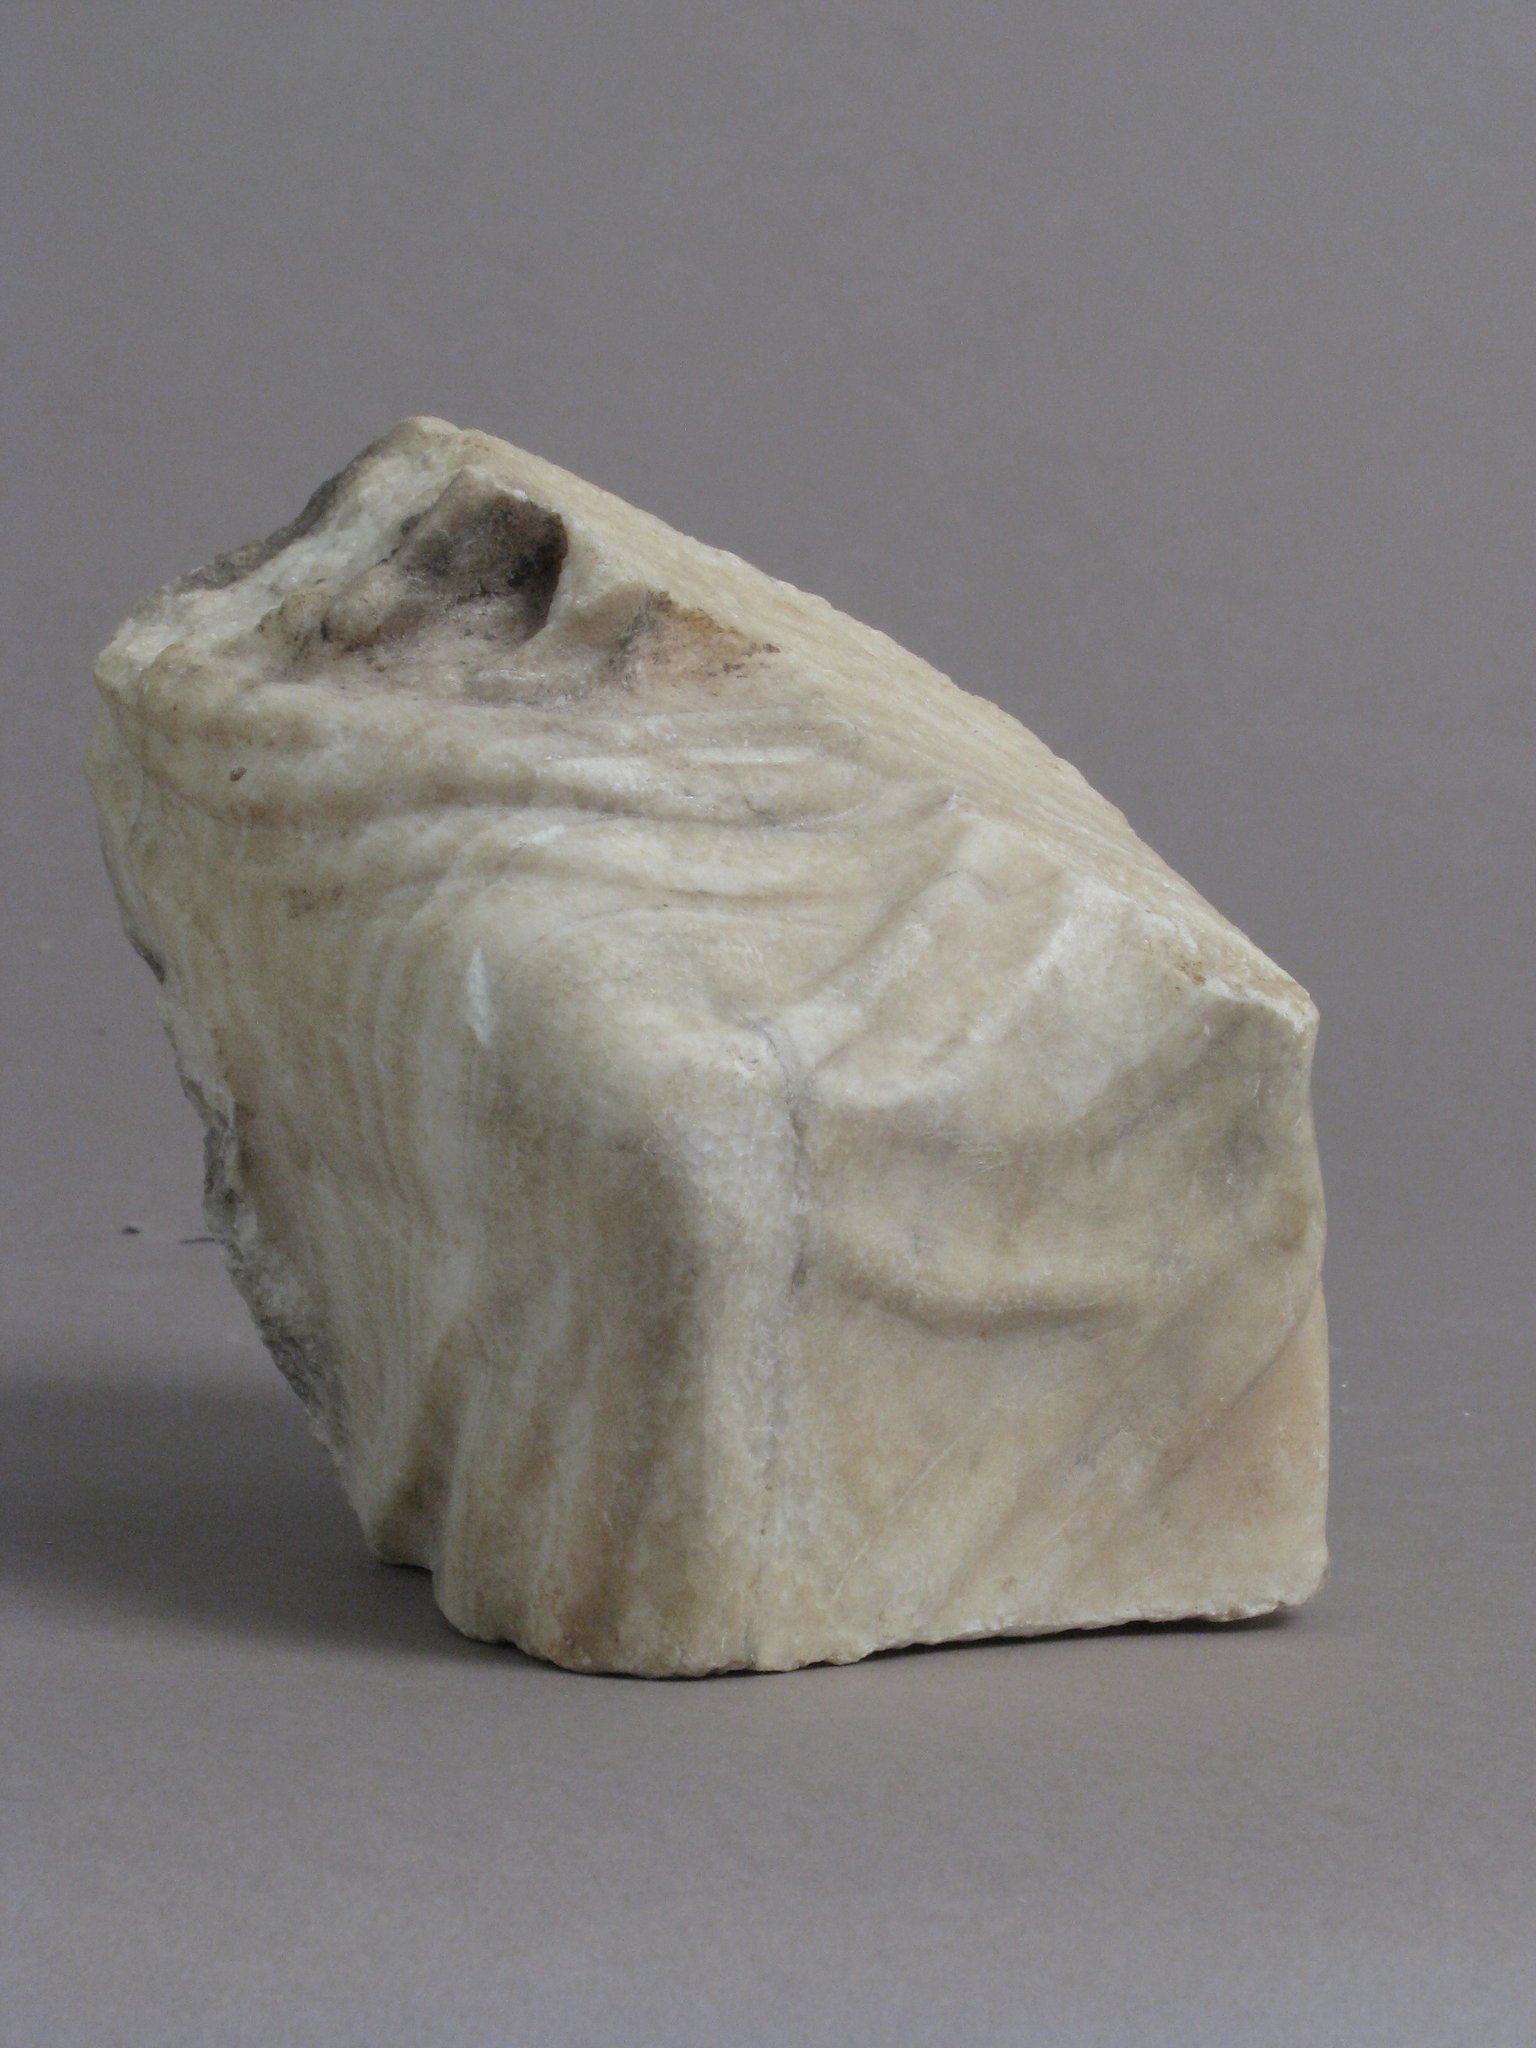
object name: statuette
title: Knee Fragment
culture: coptic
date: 301-700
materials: marble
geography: egypt